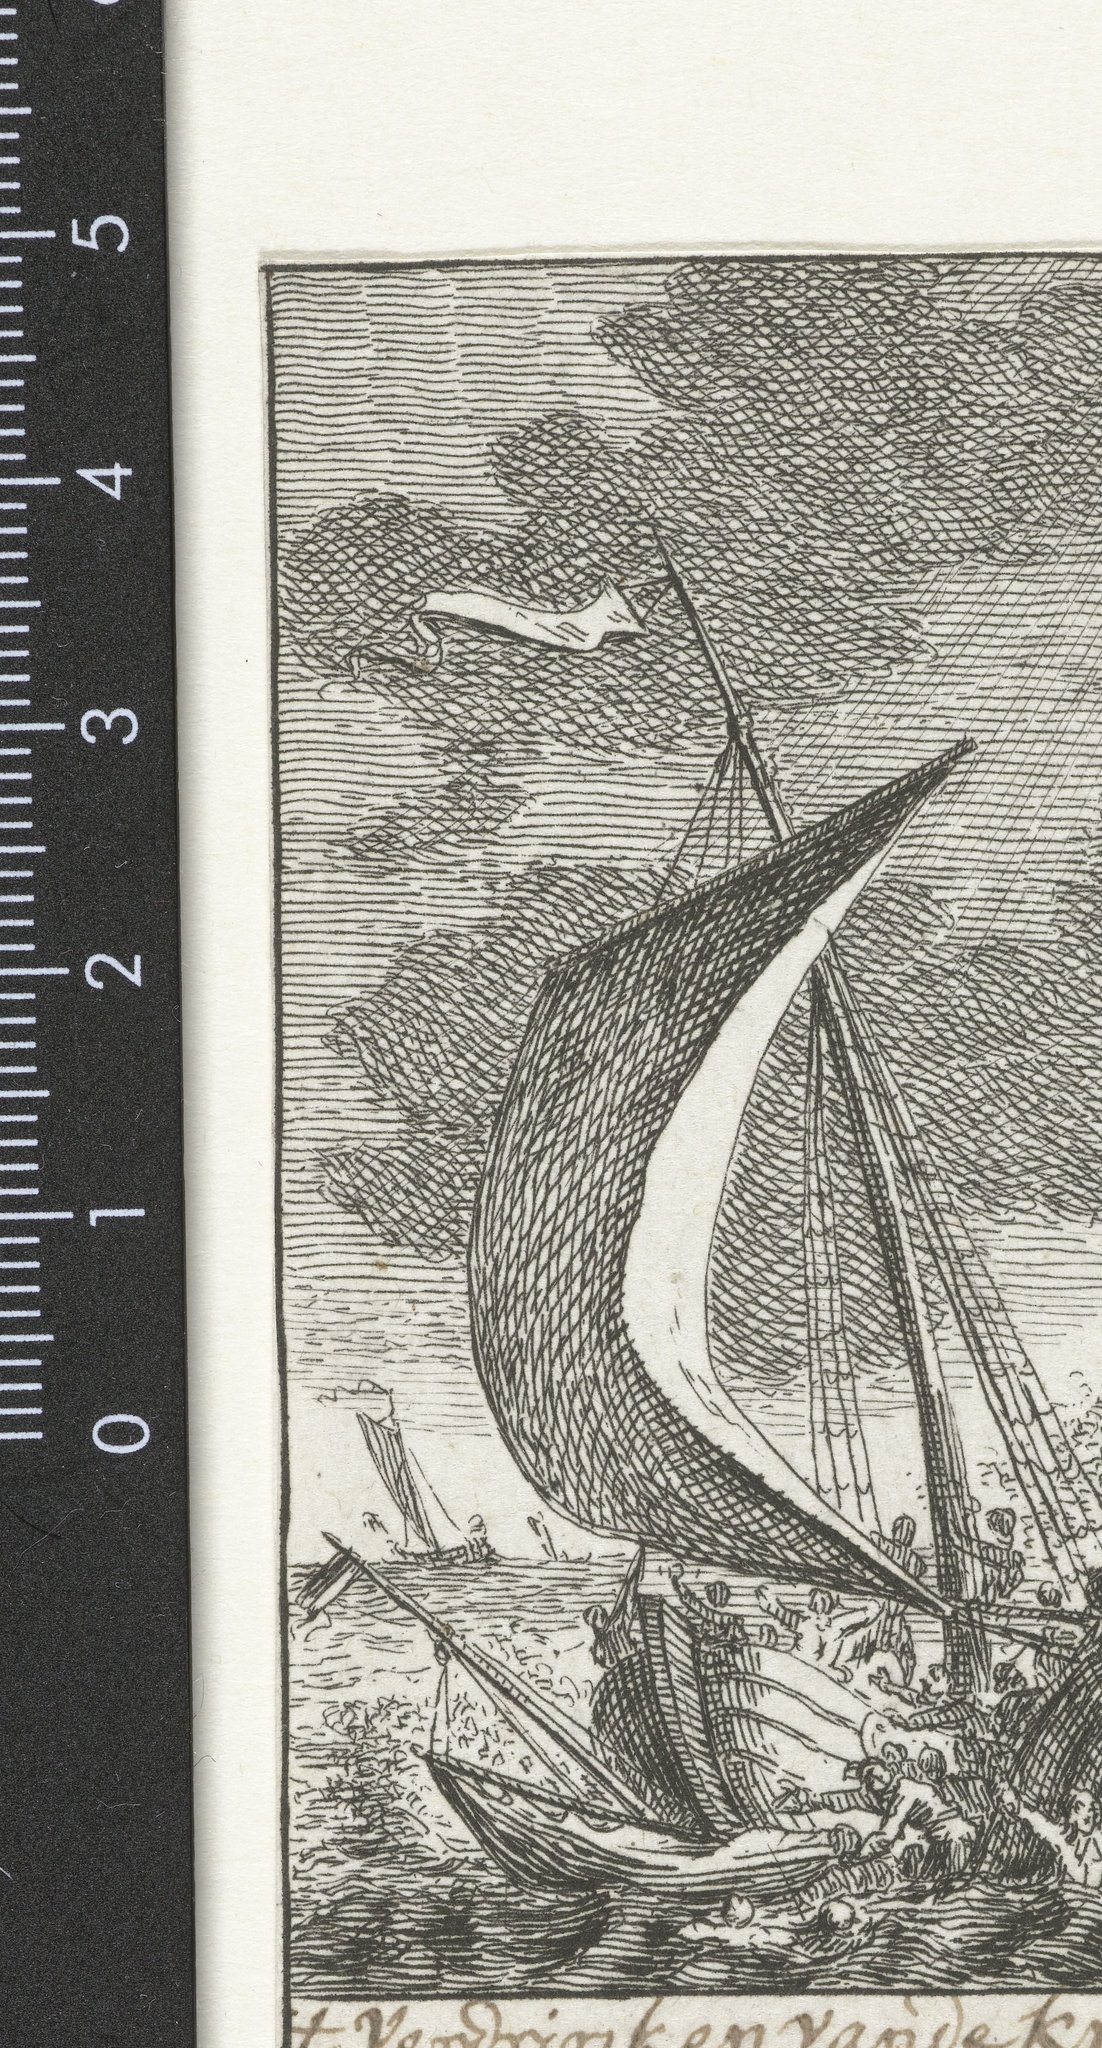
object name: print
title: De kroonprins van Bohemen verdrinkt op het IJ, 1629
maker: simon fokke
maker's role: draughtsman, print maker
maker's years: 1712-1784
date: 1722-1784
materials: paper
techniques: etching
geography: northern netherlands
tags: death by drowning (non-violent), falling overboard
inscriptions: inscription: ‘'t Verdrinken van de kroonprins van Bohemen in de Holle Sloot Ao. 1629’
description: Frederik Hendrik van de Palts, de kroonprins van Bohemen, verdrinkt in de Holle Sloot op het IJ bij een aanvaring tussen verschillende bootjes, 17 januari 1629.